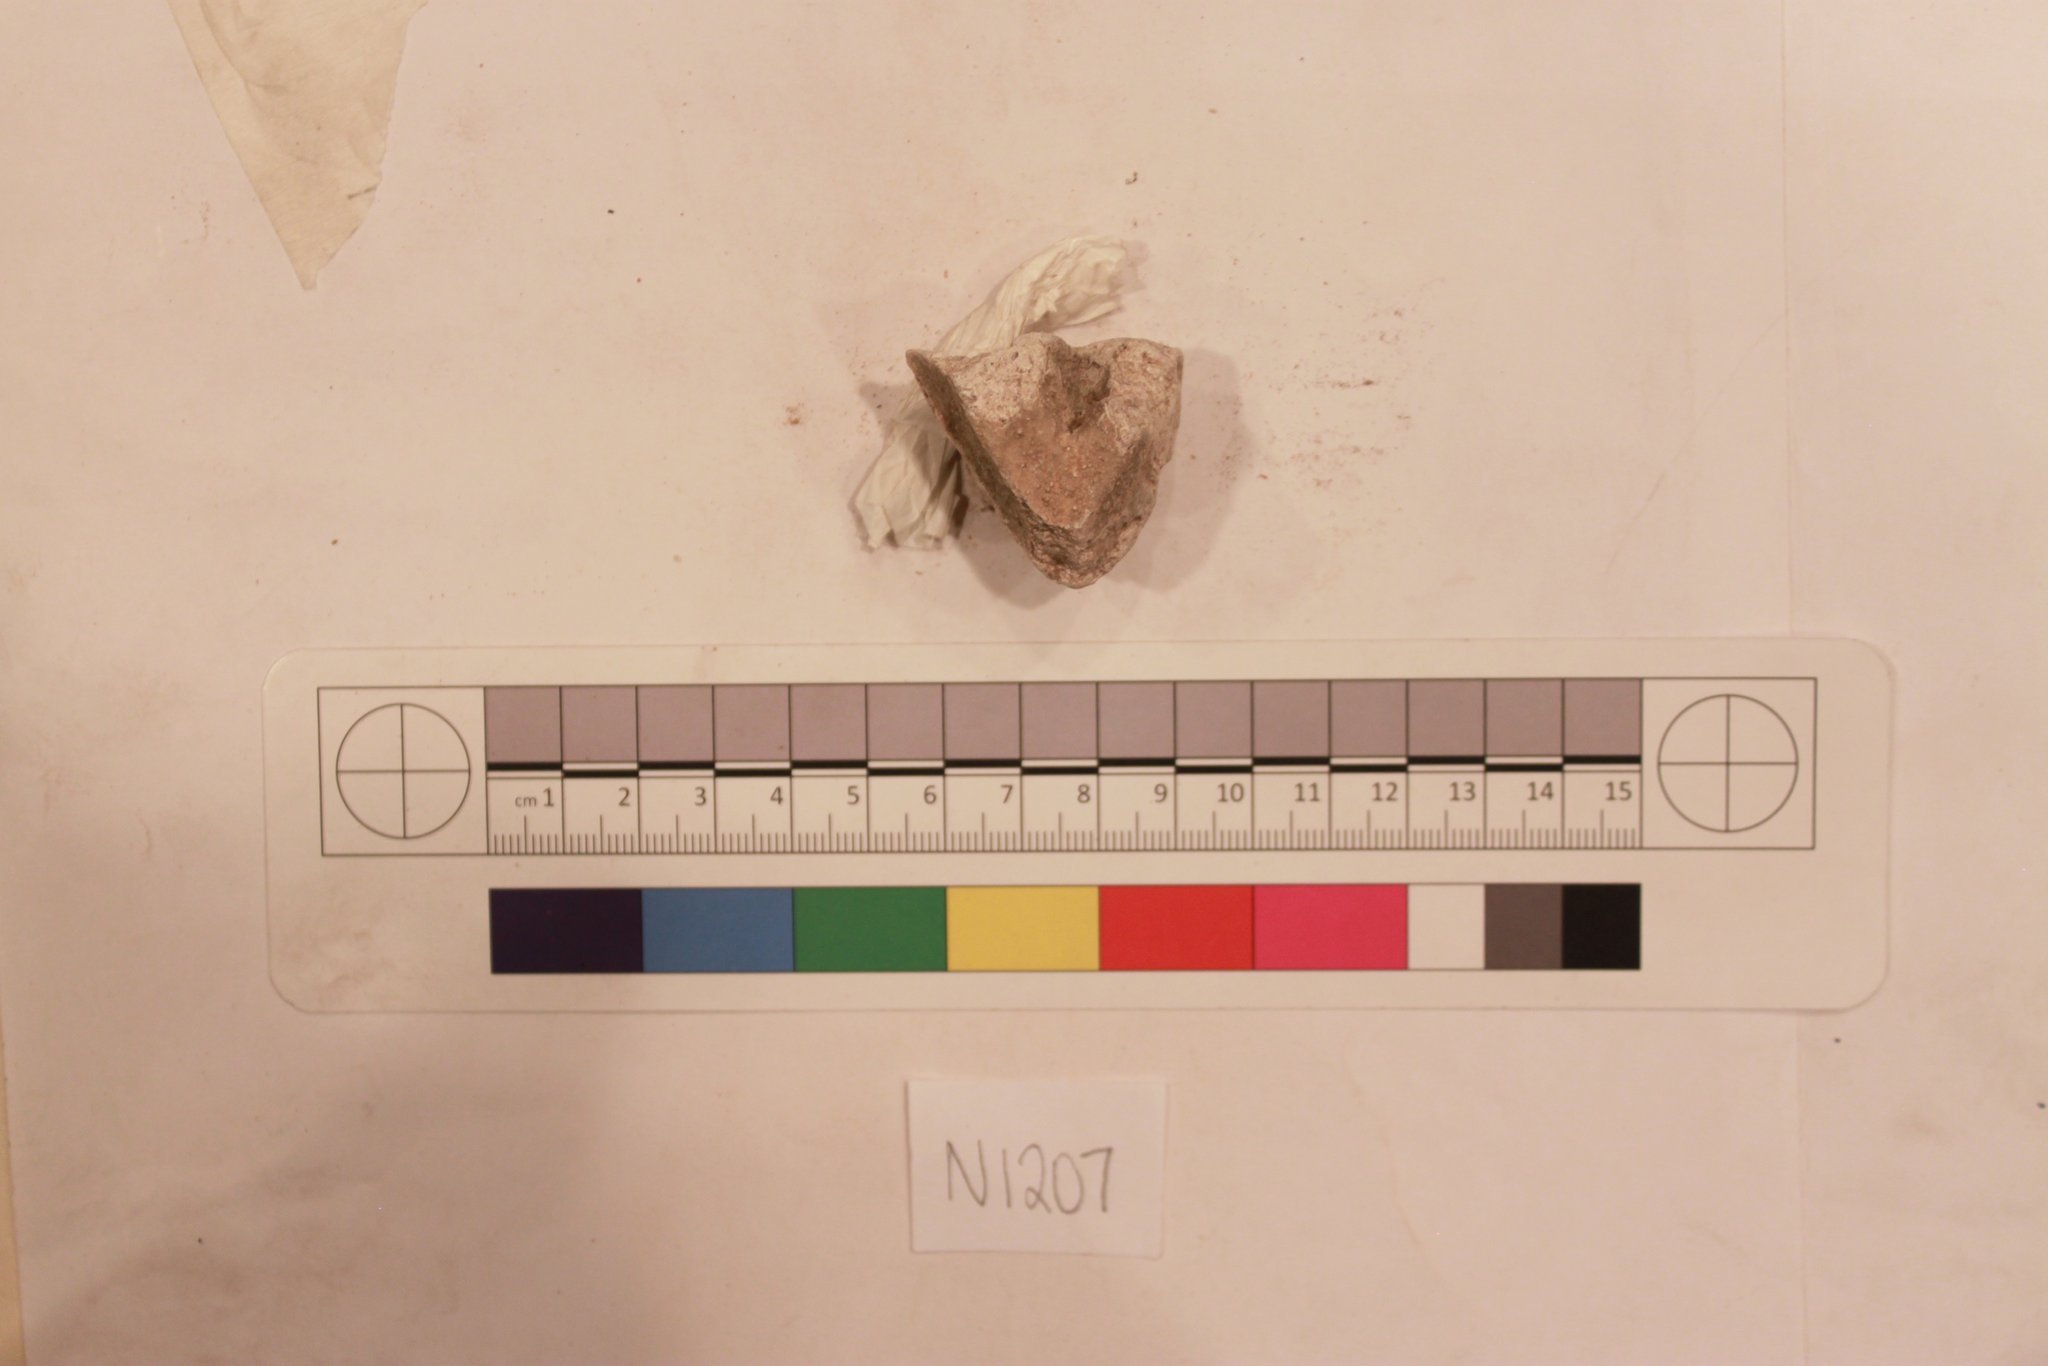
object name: fragment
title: Stucco Fragment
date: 701-1200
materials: plaster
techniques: carving, painting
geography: iran